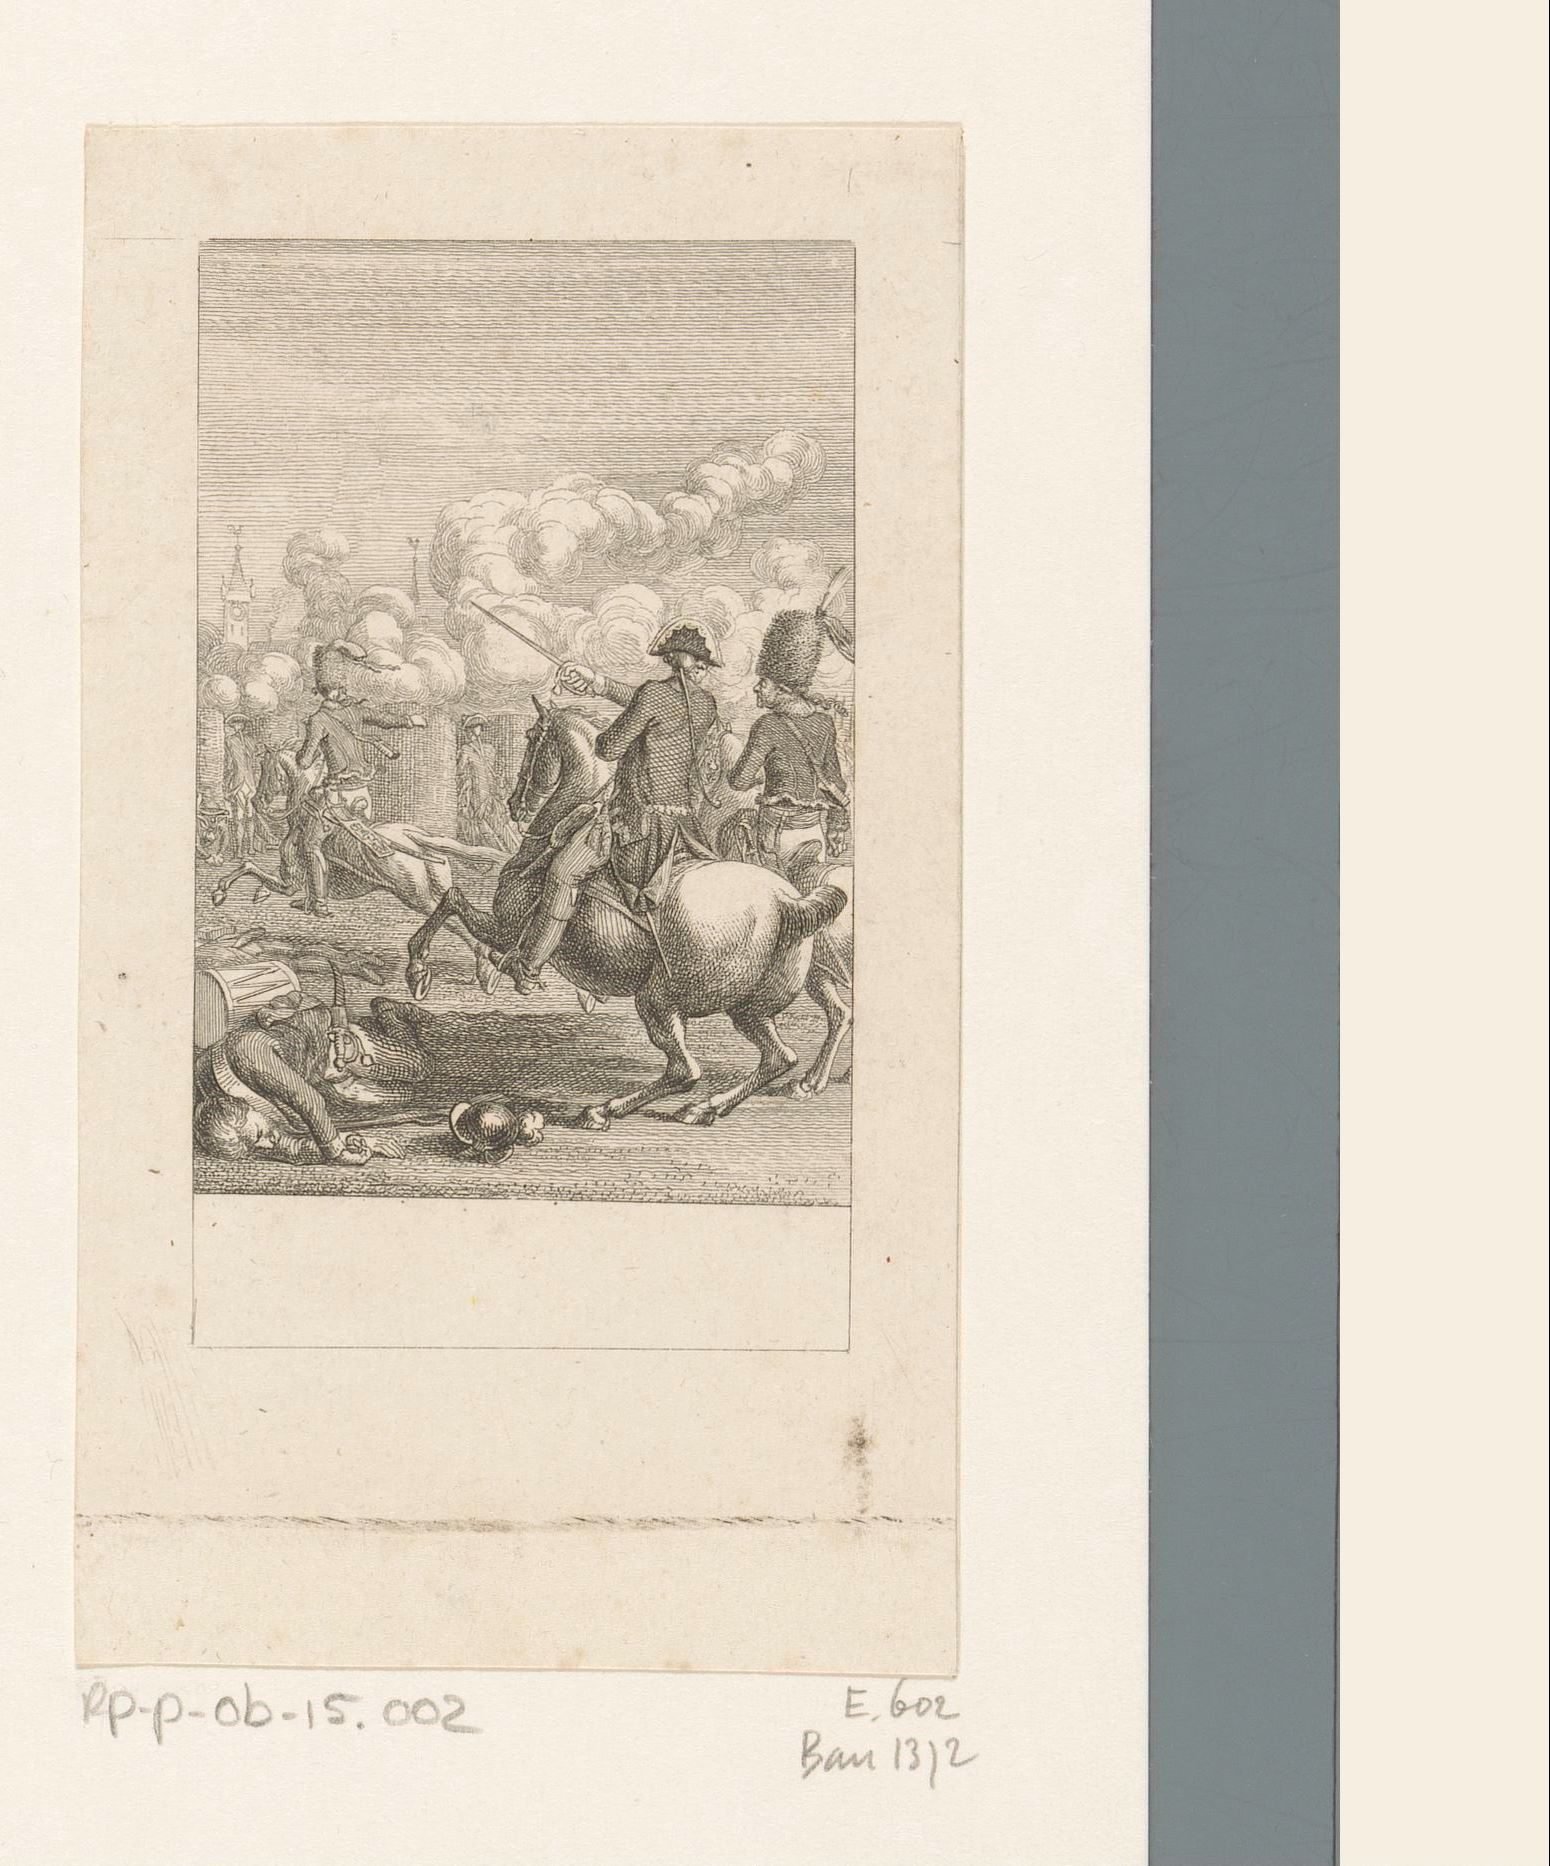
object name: print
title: Actie bij Amstelveen op 1 oktober 1787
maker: daniel nikolaus chodowiecki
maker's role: draughtsman, print maker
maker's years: 1726-1801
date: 1788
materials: paper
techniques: etching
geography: berlin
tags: riding a horse, ass, or mule; rider, horseman, history, battle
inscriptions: collector's mark: Lugt 2228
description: Latere staat gebruikt voor: Genealogischer-Militairischer Kalender auf das Jahr 1789. Berlijn: s.n., [1788].